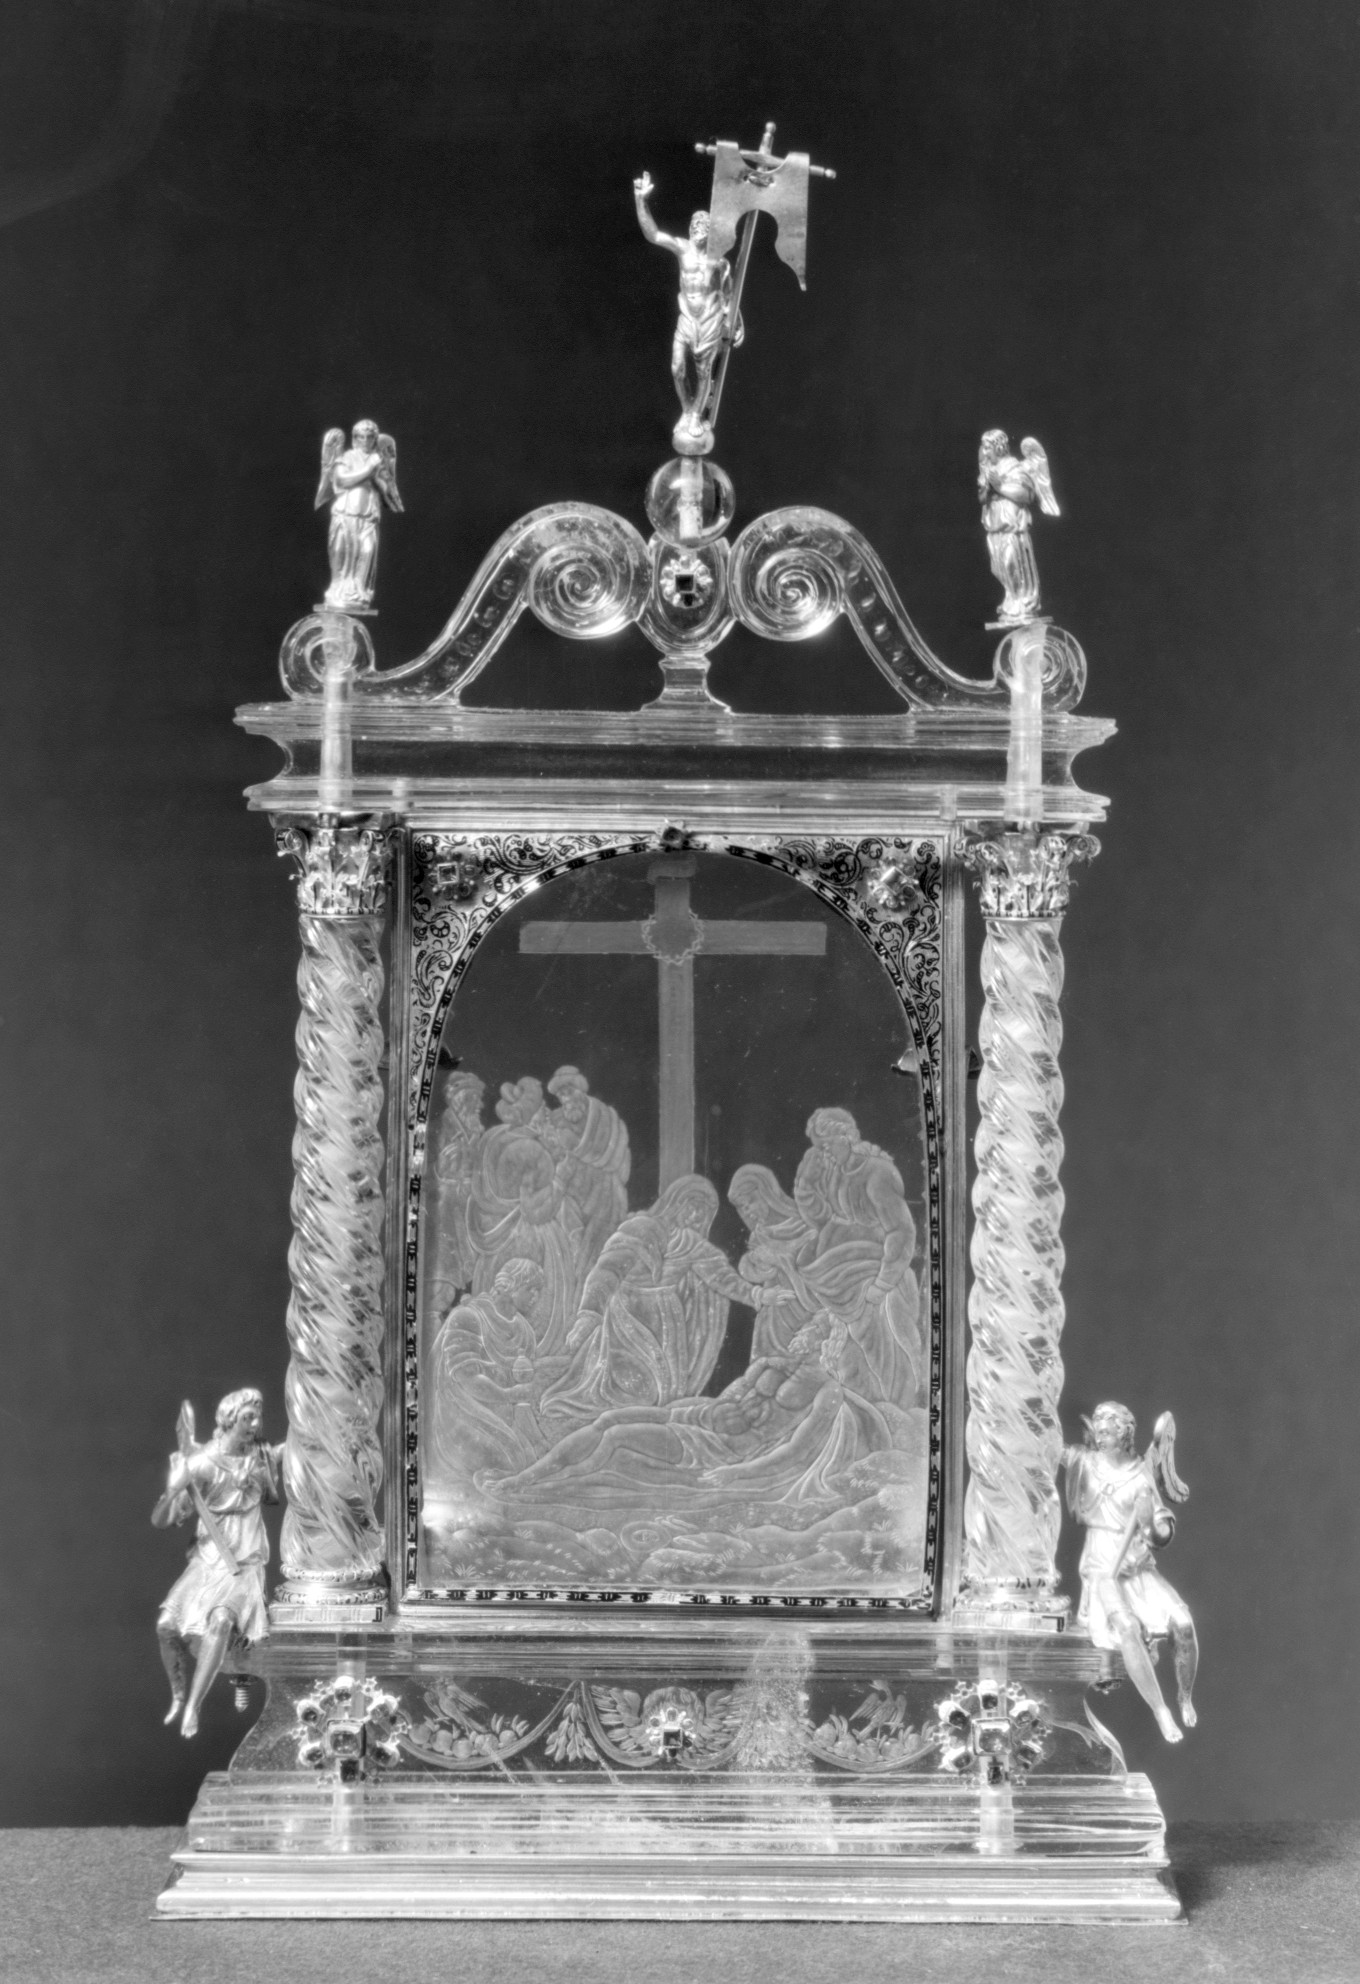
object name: pax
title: Pietà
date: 1851-1900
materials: crystal, gemstone, enamel, silver gilt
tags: angels,christ,cross